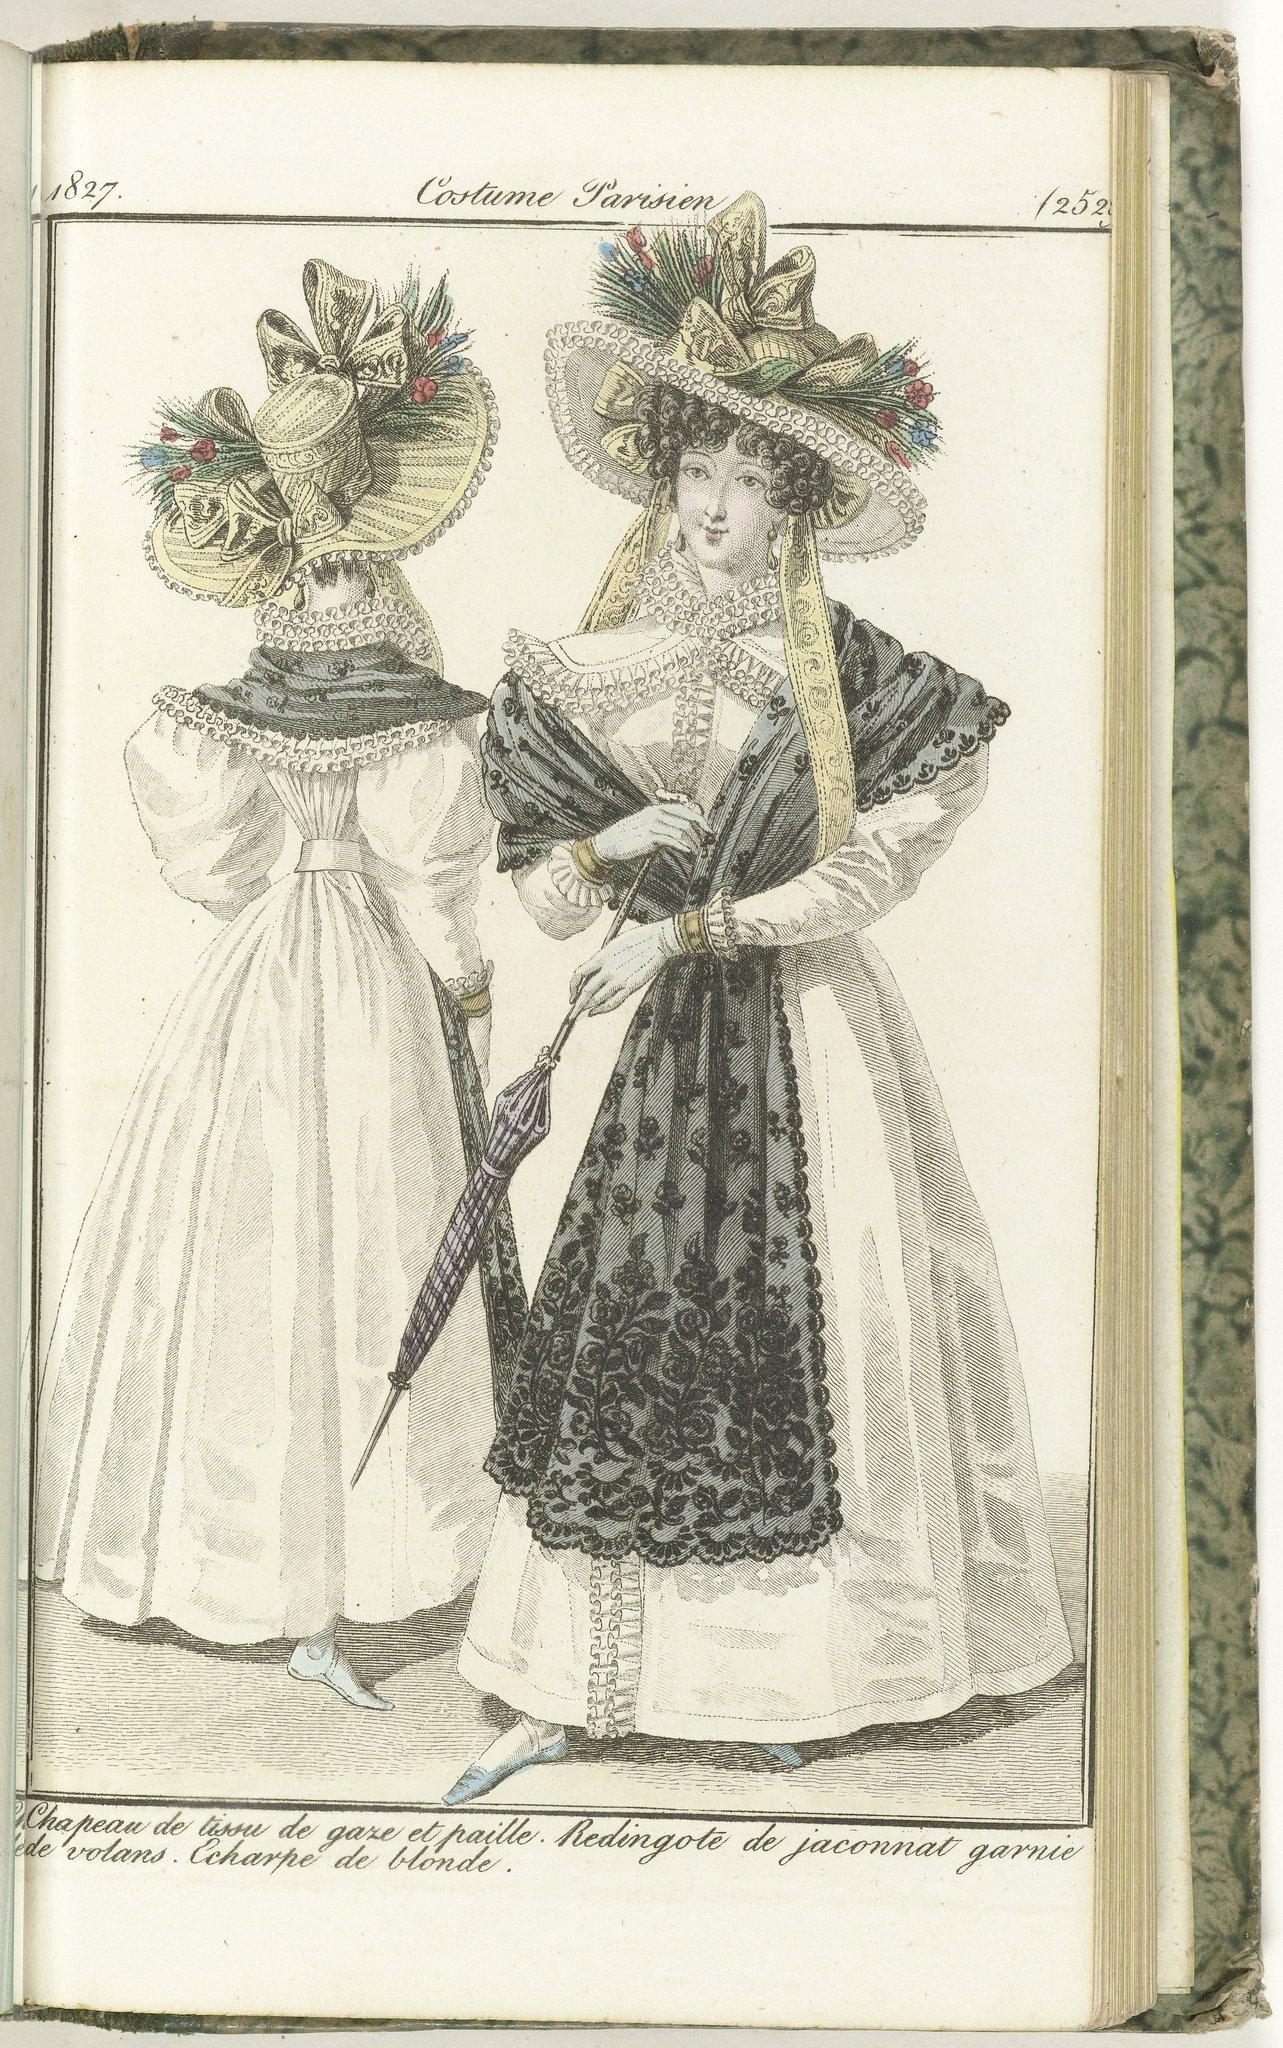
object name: fashion print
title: Journal des Dames et des Modes, Costume Parisien, 25 août 1827, (2529): Chapeau de tissu de gaze...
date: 1827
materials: paper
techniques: engraving, hand coloring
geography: paris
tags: clothing for the upper part of the body (shawl) (+ women's clothes), walking-stick, staff, cane (+ women's clothes), dress, gown: redingote (+ women's clothes), clothing for the upper part of the body (shawl) (+ lace used for clothes), fashion plates, head-gear: hat (+ women's clothes)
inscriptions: caption: ‘Chapeau de tissu de gaze et paille. Redingote de jaconnat garnie de volans. Echarpe de blonde.’, title: ‘Costume Parisien’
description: Hoed van gaze en stro, versierd met strikken en bloemen. Redingote (jasjurk) van 'jaconnat', gegarneerd met stroken afgezet met 'rouleaux' van satijn. Omslagdoek van blonde (kloskant). Verdere accessoires: oorbellen, handschoenen, parasol. Figuur in eenzelfde japon, op de rug gezien. De prent maakt deel uit van het modetijdschrift Journal des Dames et des Modes, uitgegeven door Pierre de la Mésangère, Parijs, 1797-1839. Ingebonden met Le Petit Courrier des Dames. 15 Januari 1827 t/m 20 maart 1830. Incompleet.